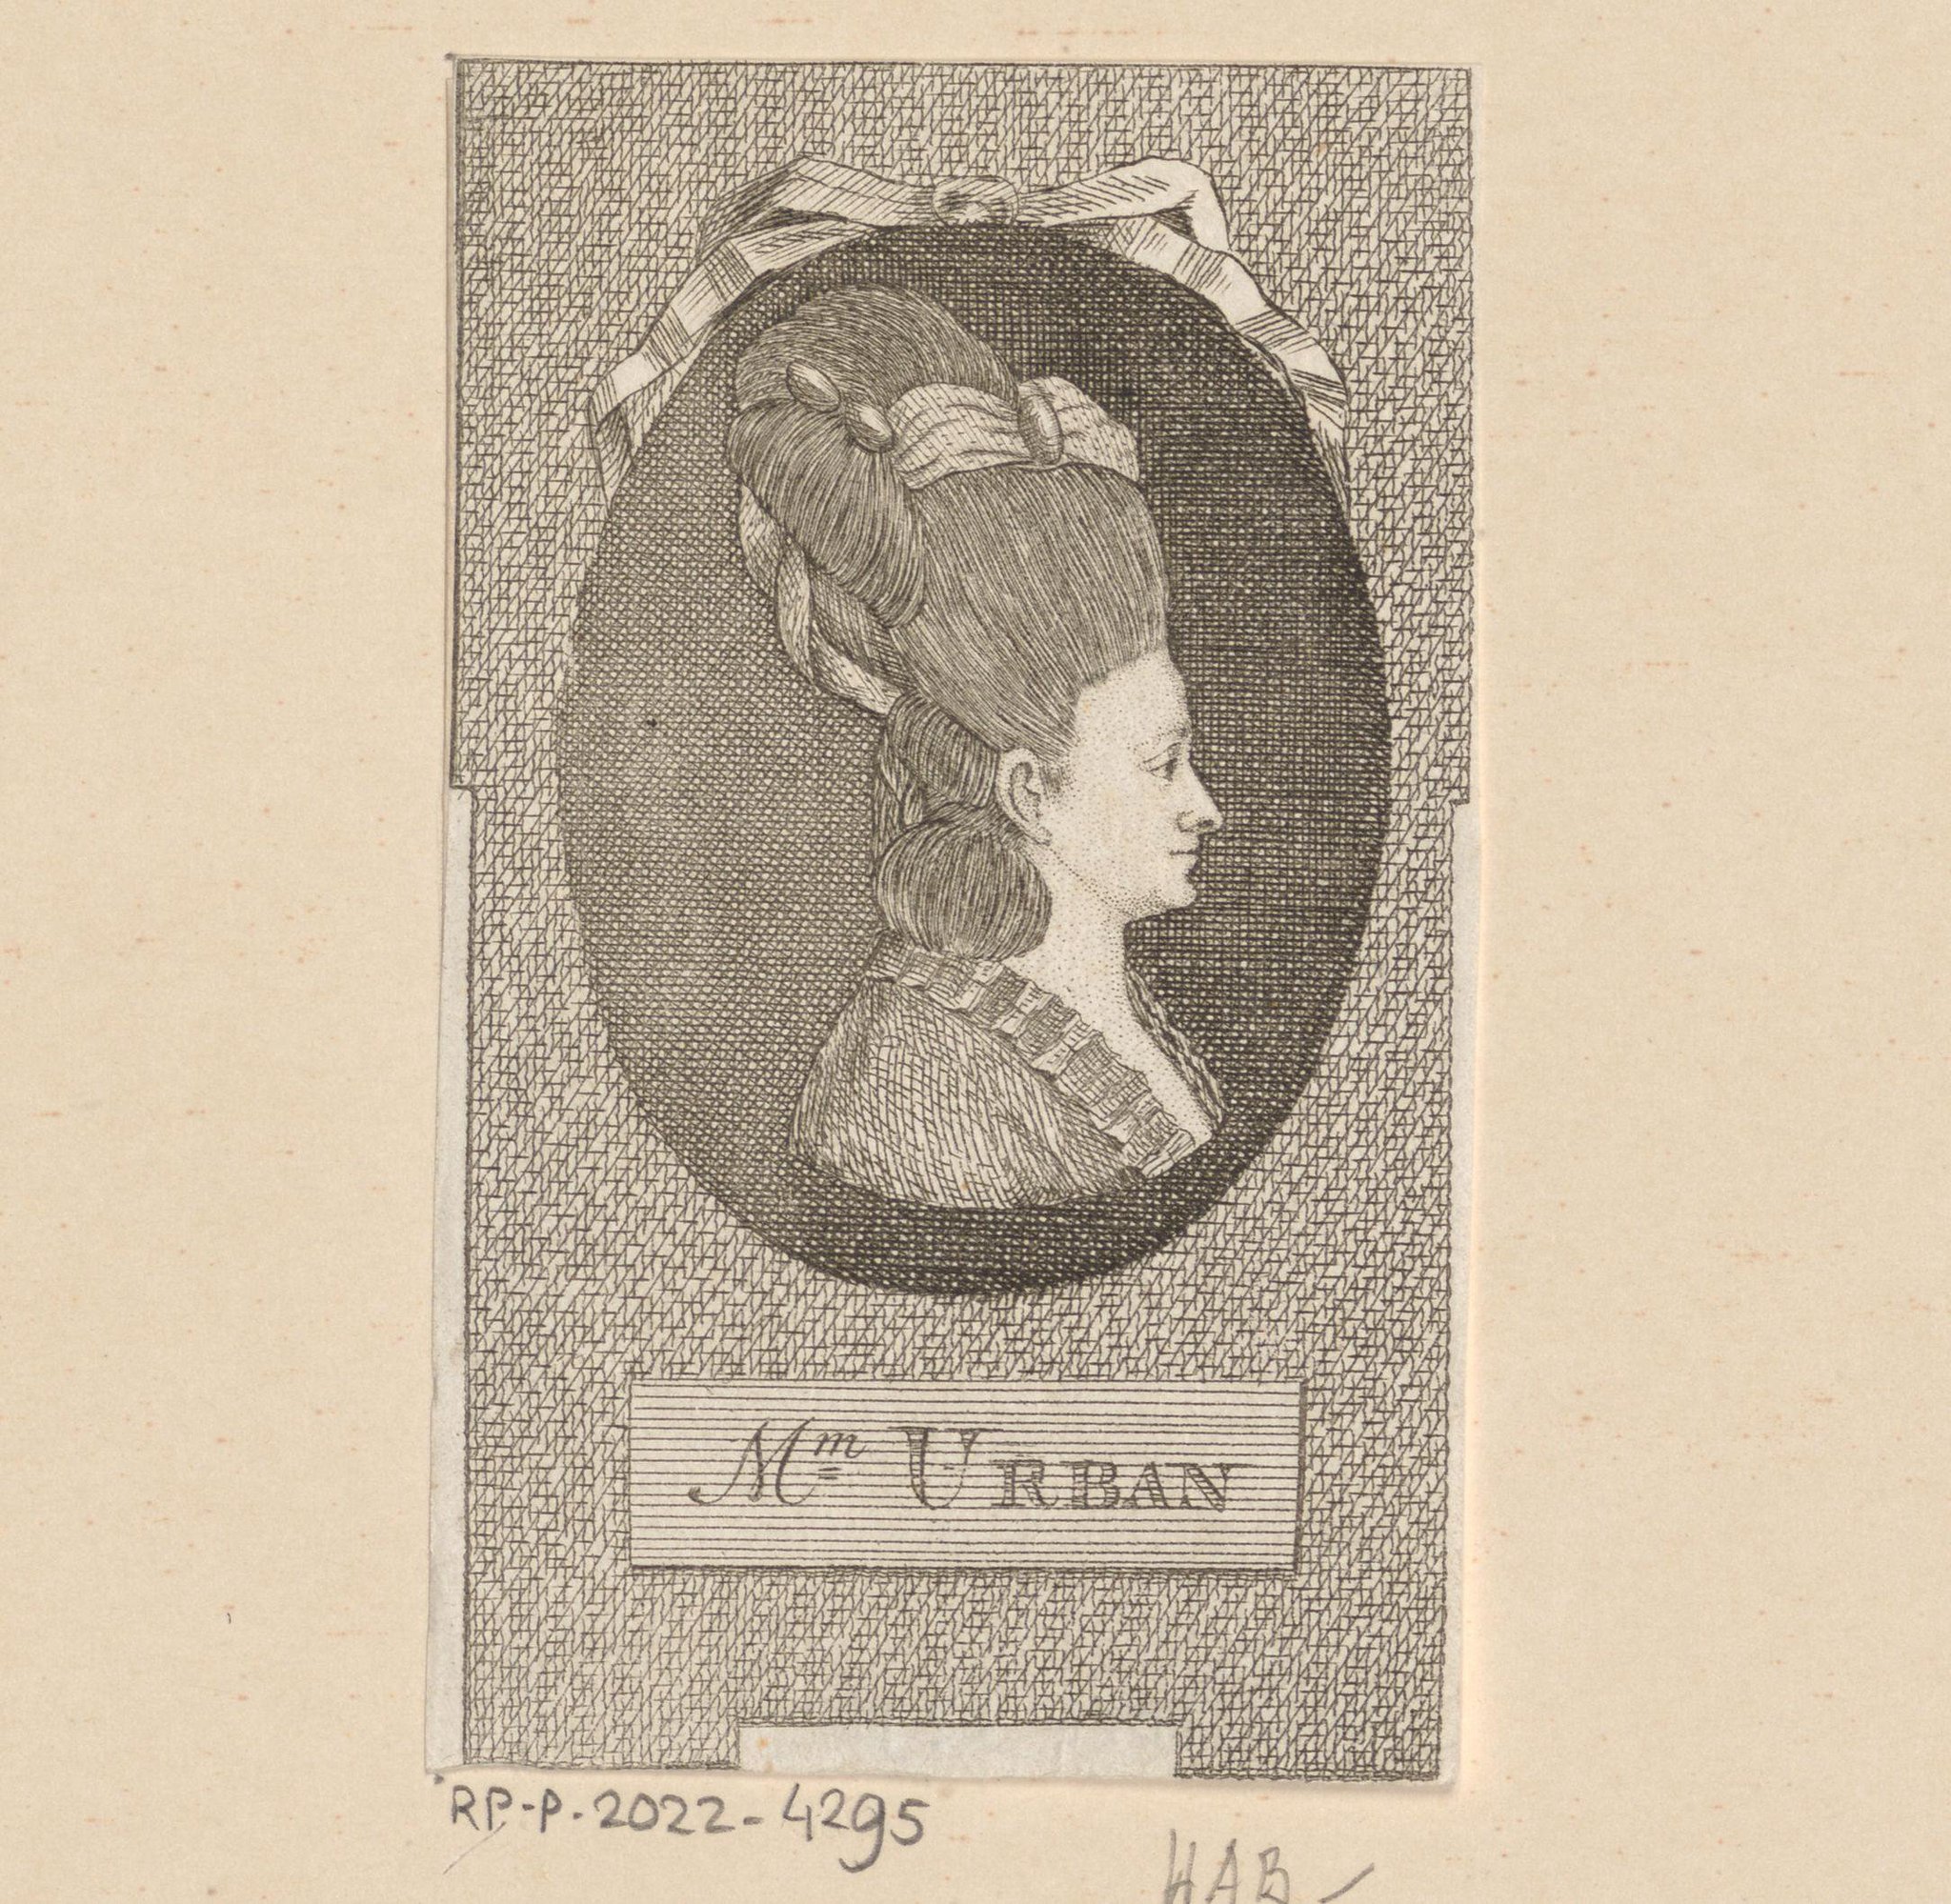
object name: print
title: Mm Urban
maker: Anonymous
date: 1700-1800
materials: paper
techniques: engraving, etching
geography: france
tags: historical persons not known by name - bb - woman